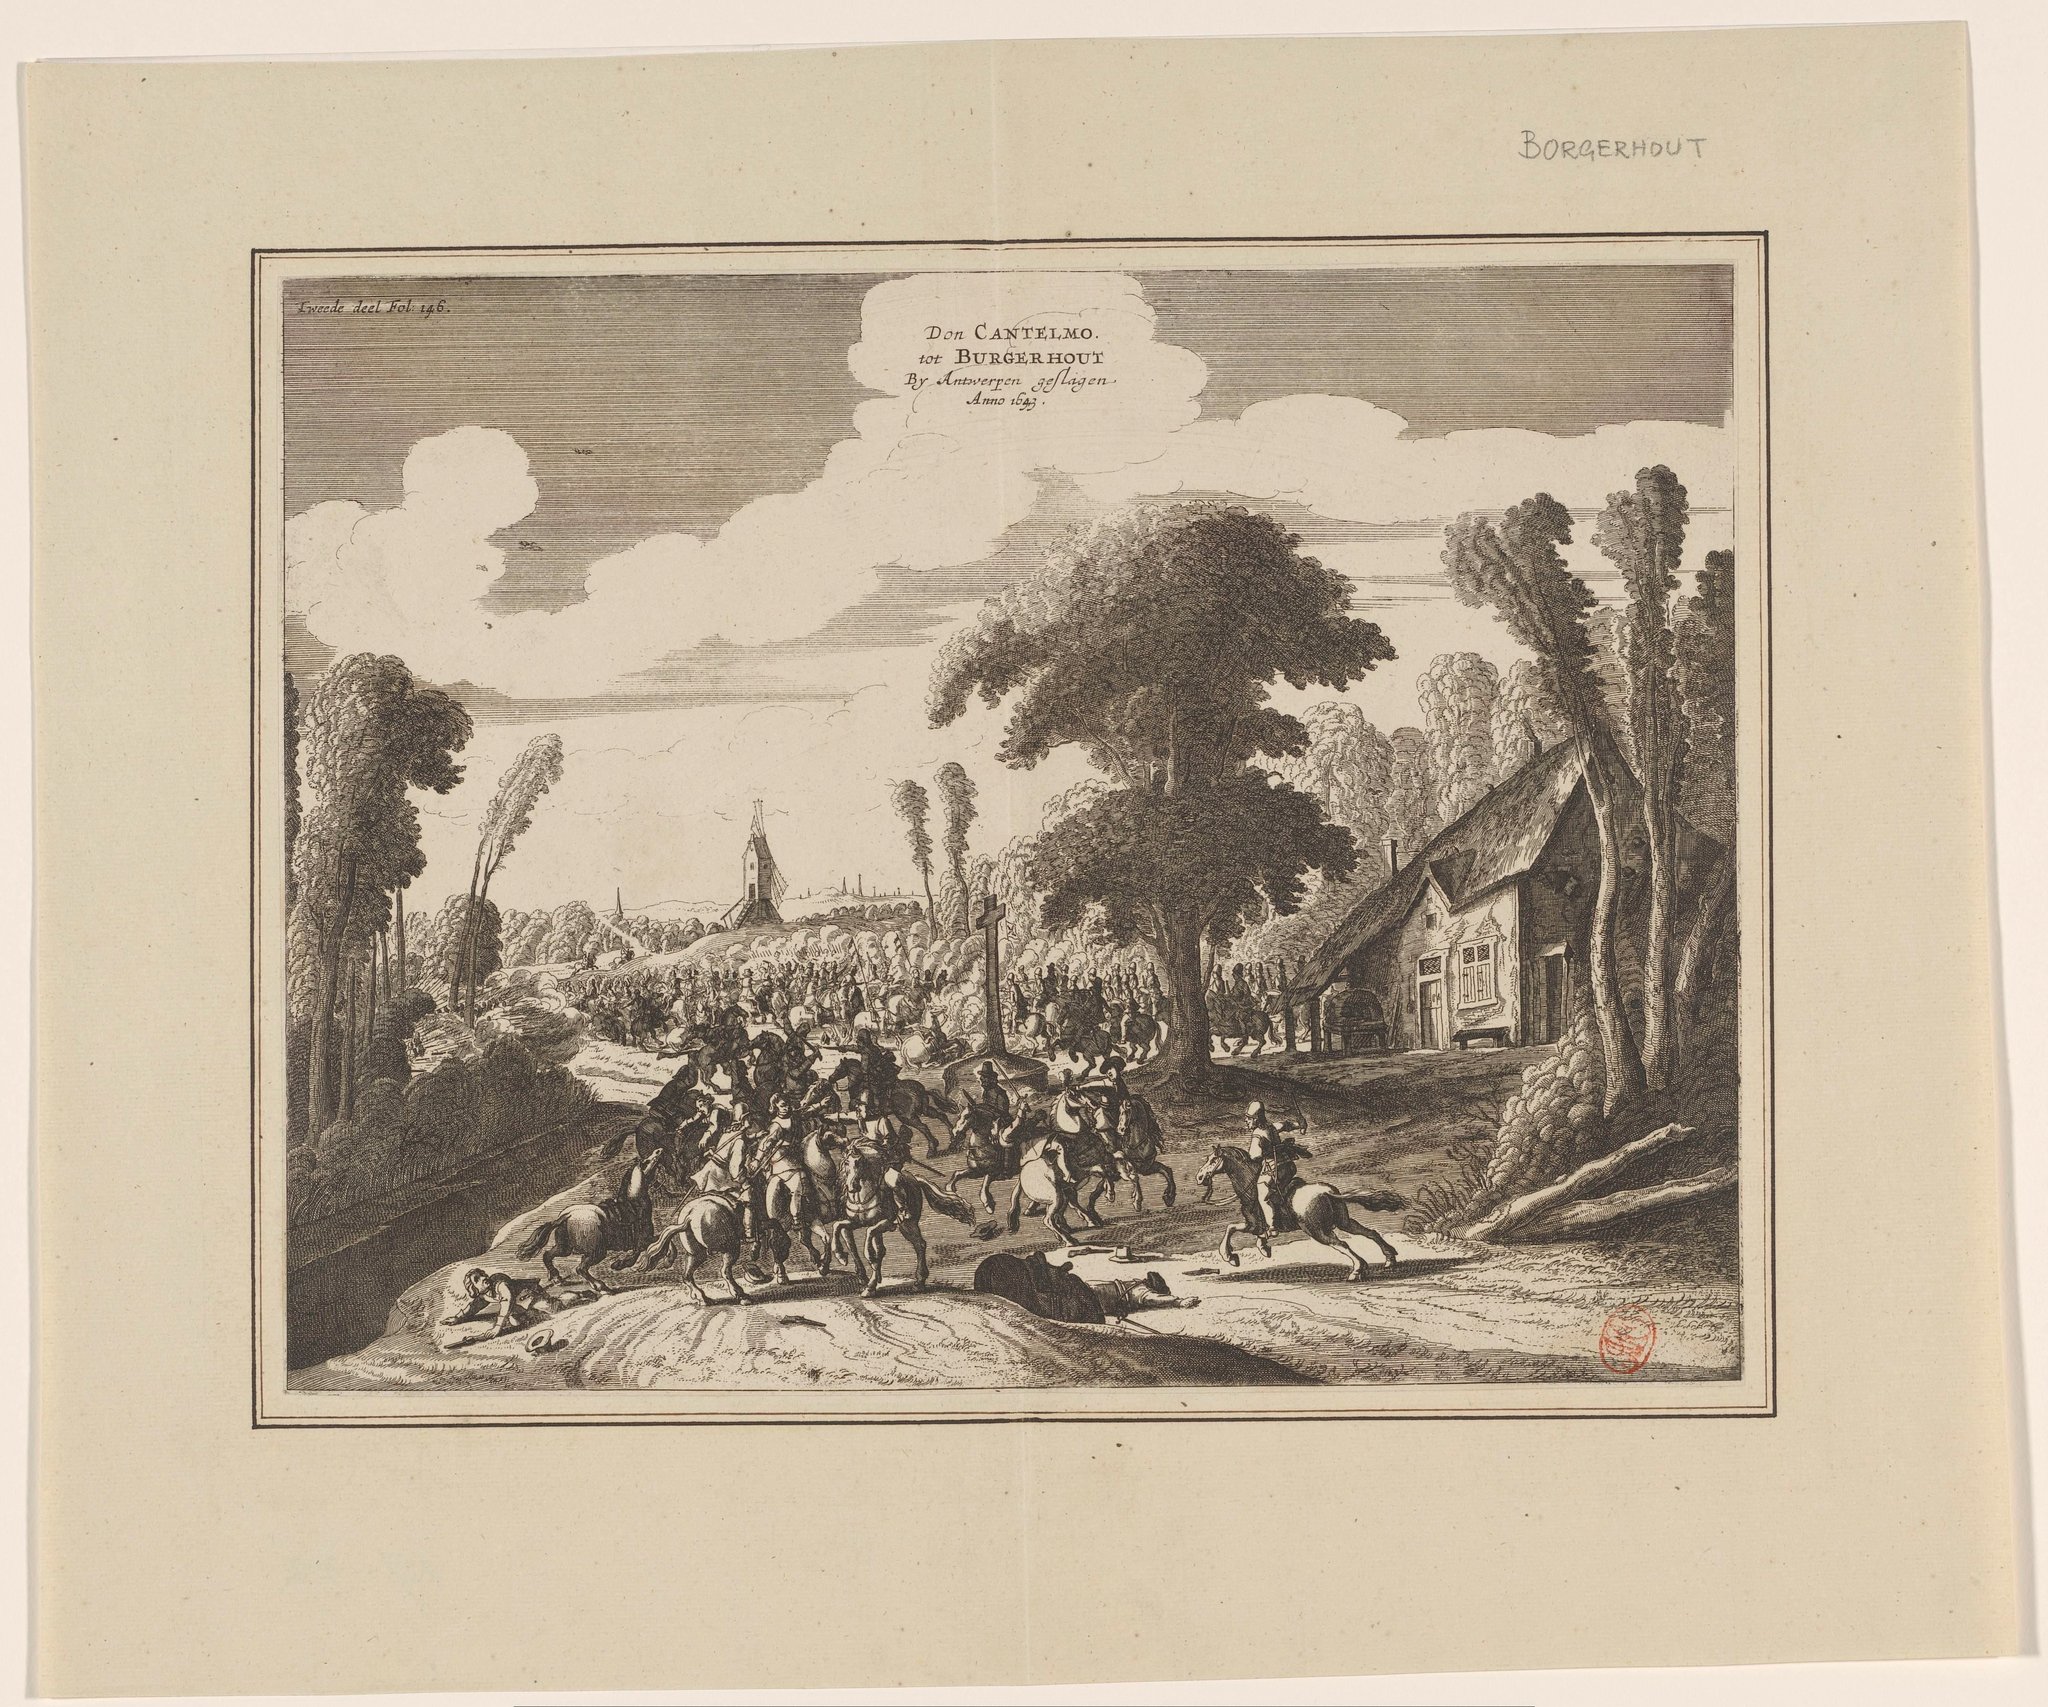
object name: history print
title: Spanjaarden onder Don Cantelmo bij Borgerhout verslagen, 1643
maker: Anonymous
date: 1649-1651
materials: paper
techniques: engraving, etching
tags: william ii (prince of orange), don andrea cantelmo, battle (+ land forces)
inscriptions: collector's mark: Lugt 195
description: Gevecht bij Borgerhout in de buurt van Antwerpen waarbij een Spaans leger van Don Andrea Cantelmo onder bevel van Don Juan de Borges is verslagen door de Staatse troepen onder bevel van prins Willem II, 4 september 1643. Ruitergevecht in het dorp. Gemerkt linksboven: Tweede deel Fol: 146.